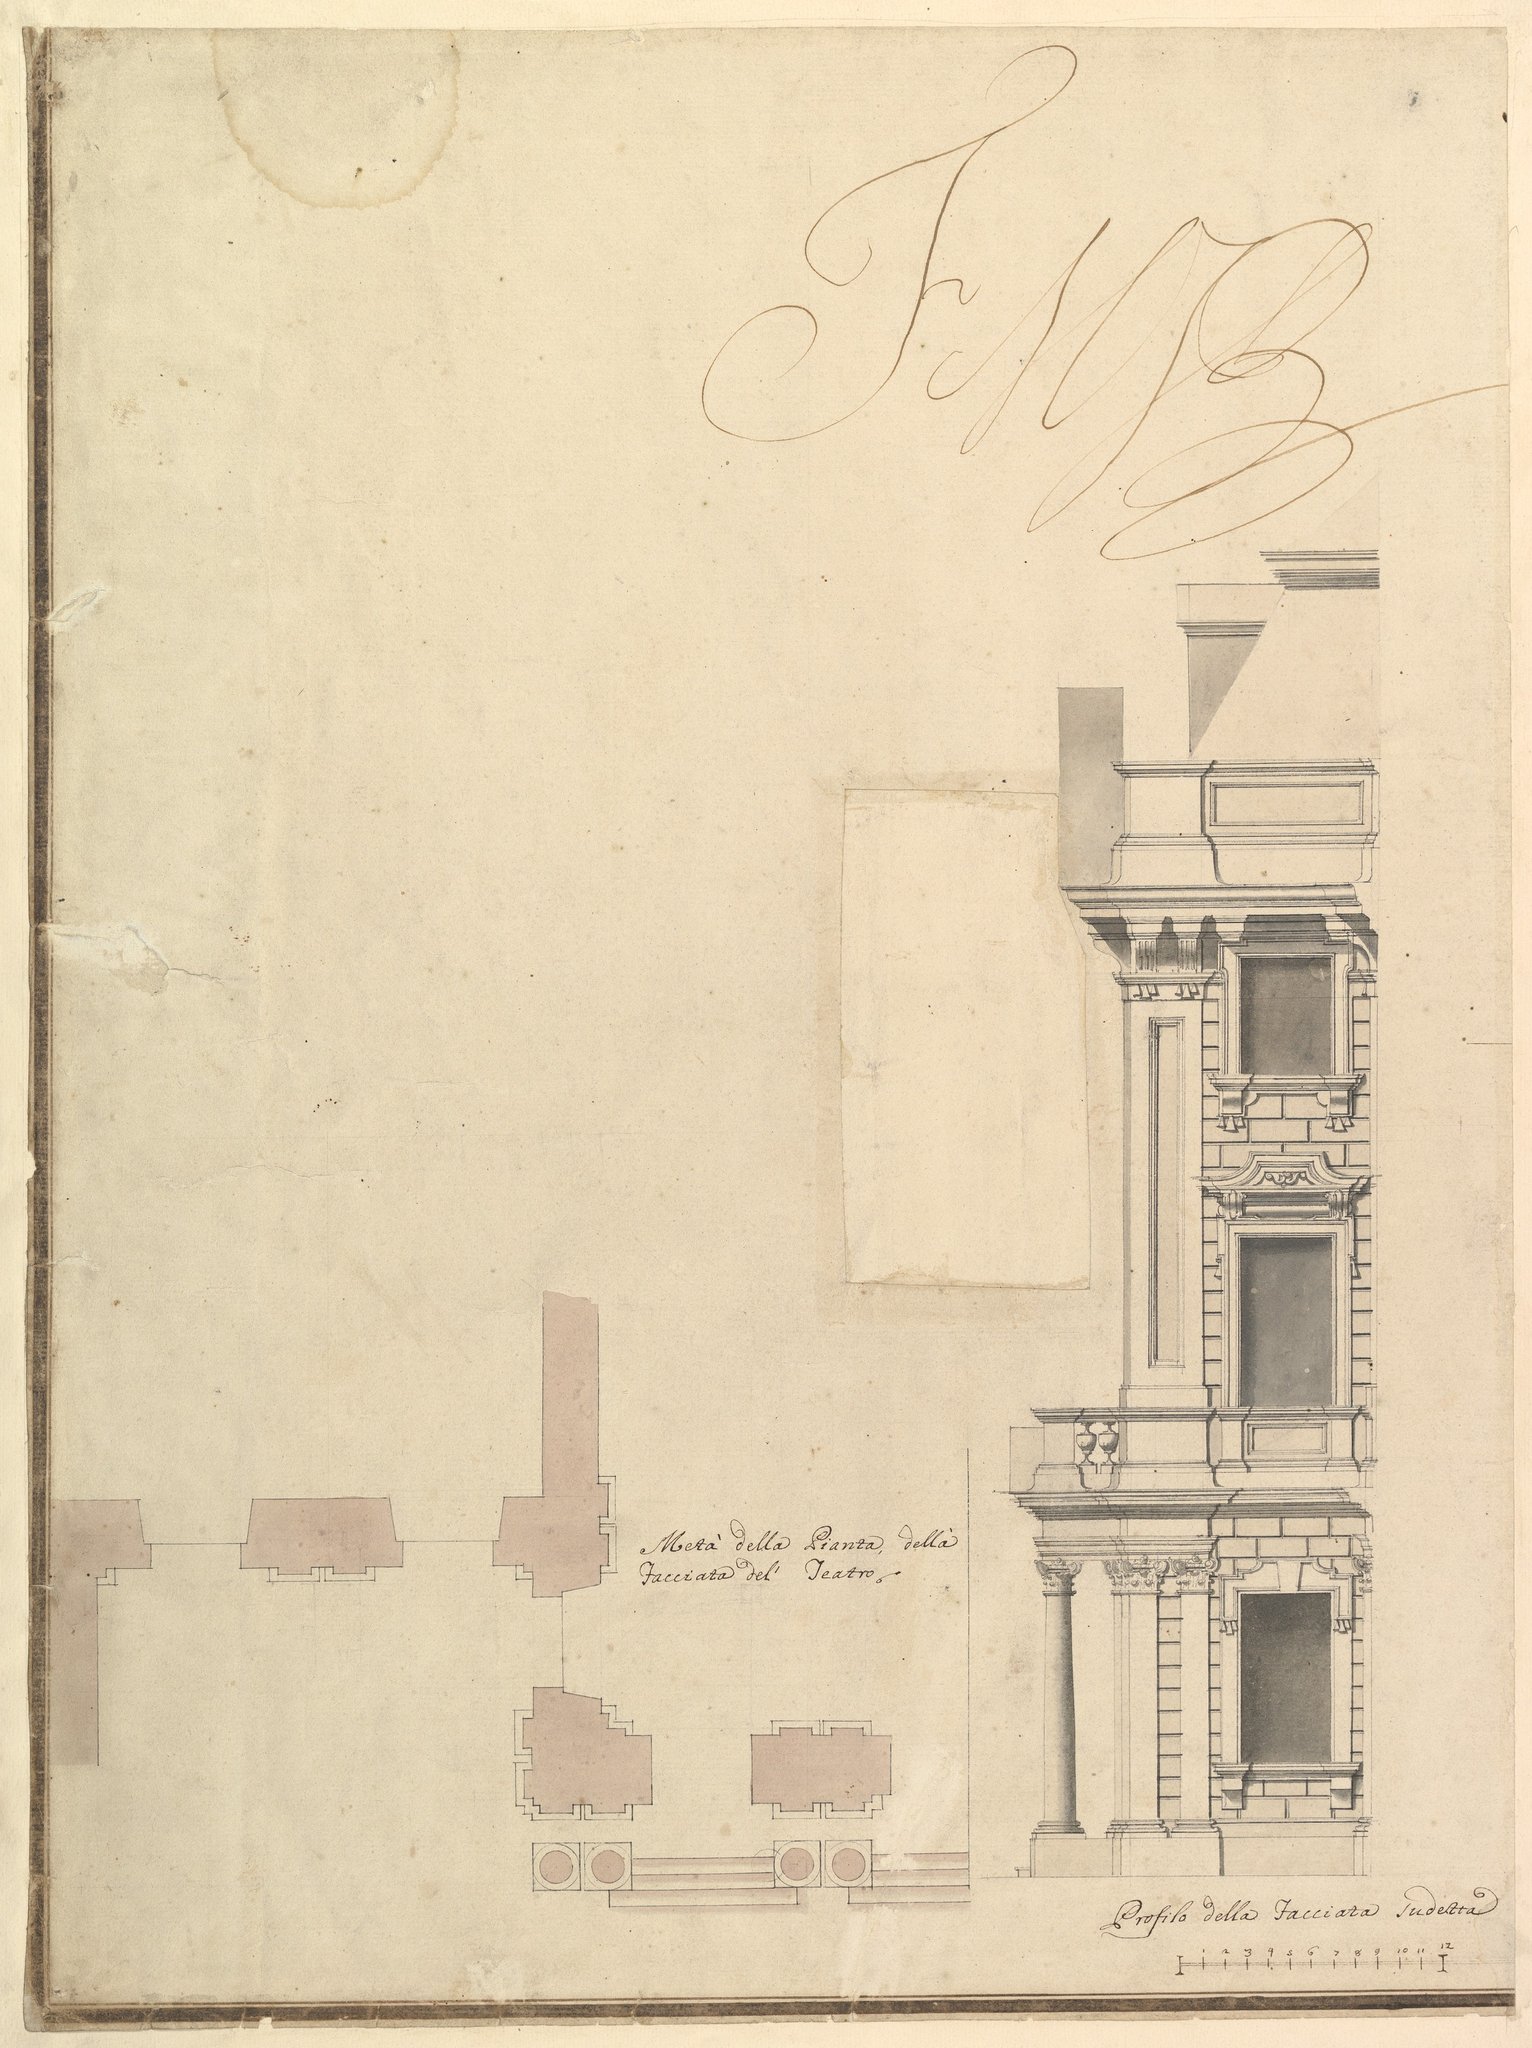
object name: drawing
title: Views of a Theater (Bayreuth): Profile View of Facade and Half of the Plan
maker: giuseppe galli bibiena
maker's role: artist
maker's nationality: italian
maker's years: 1696-1756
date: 1696-1756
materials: ink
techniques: pen, wash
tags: theatre,architecture